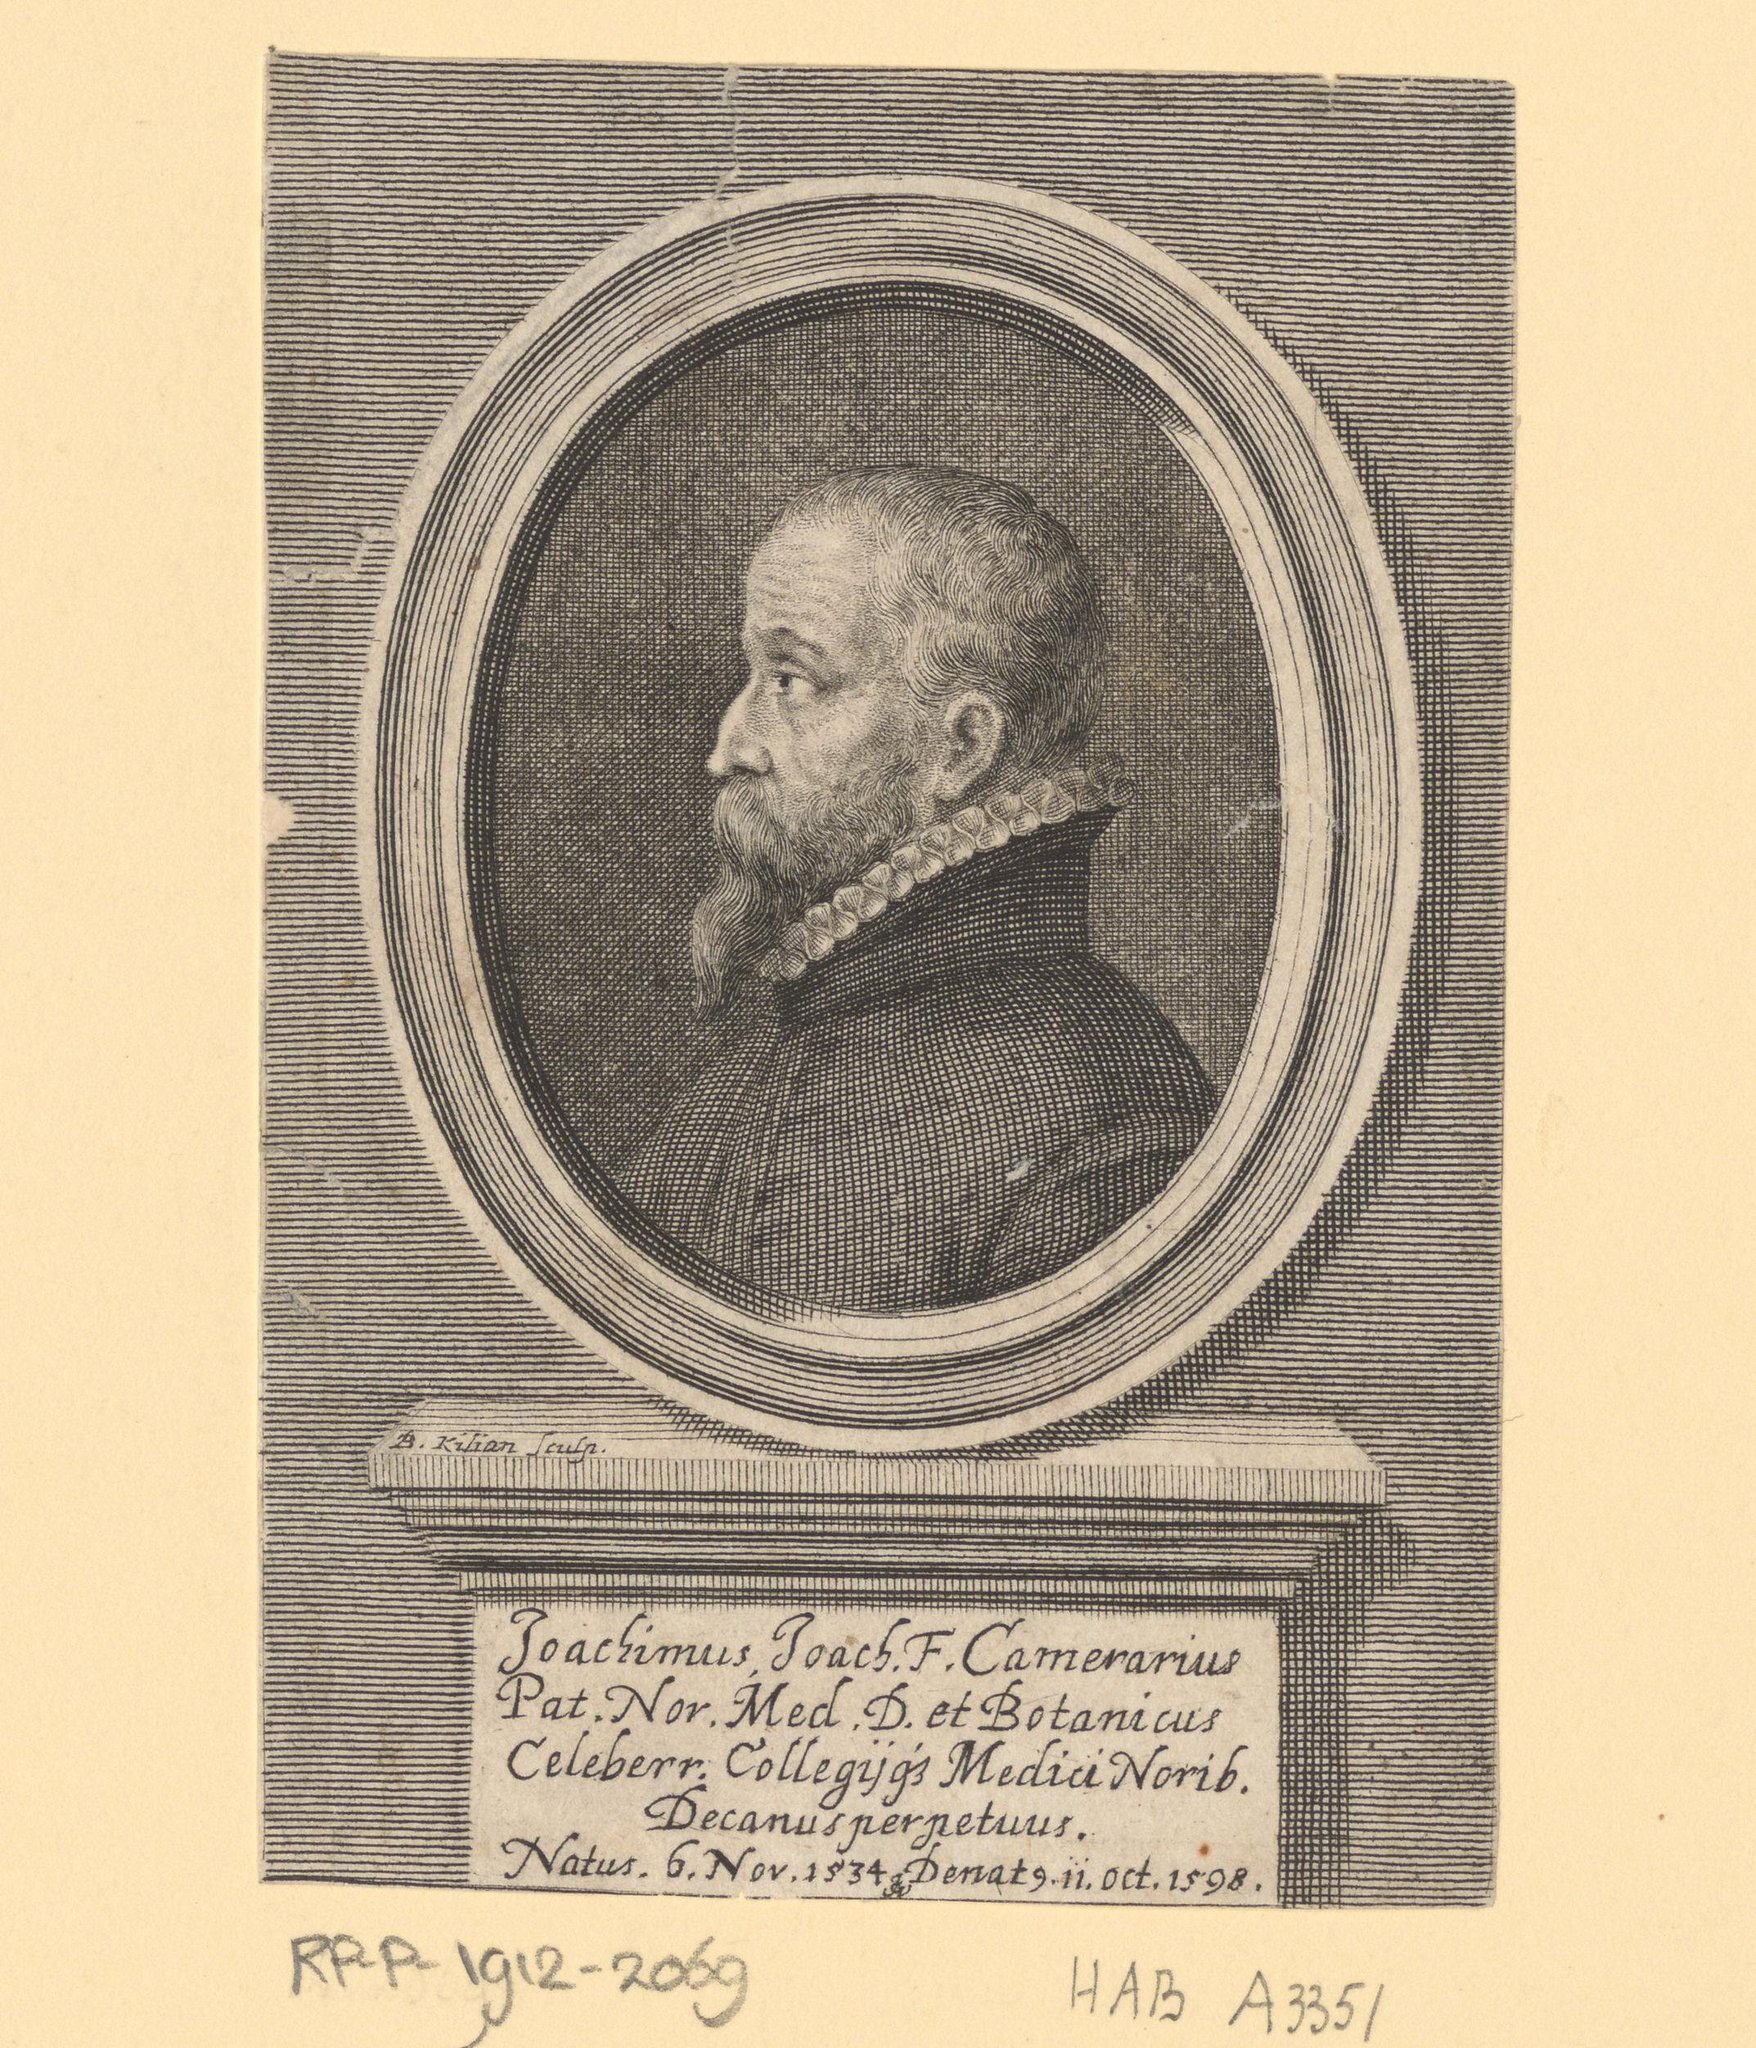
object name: print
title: Portret van Joachim Camerarius II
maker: bartholomäus kilian (ii)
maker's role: artist, draughtsman, print maker, publisher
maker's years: 1630-1696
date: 1640-1696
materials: paper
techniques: engraving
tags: historical persons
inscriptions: stamp: ‘V’, collector's mark: Lugt 2228